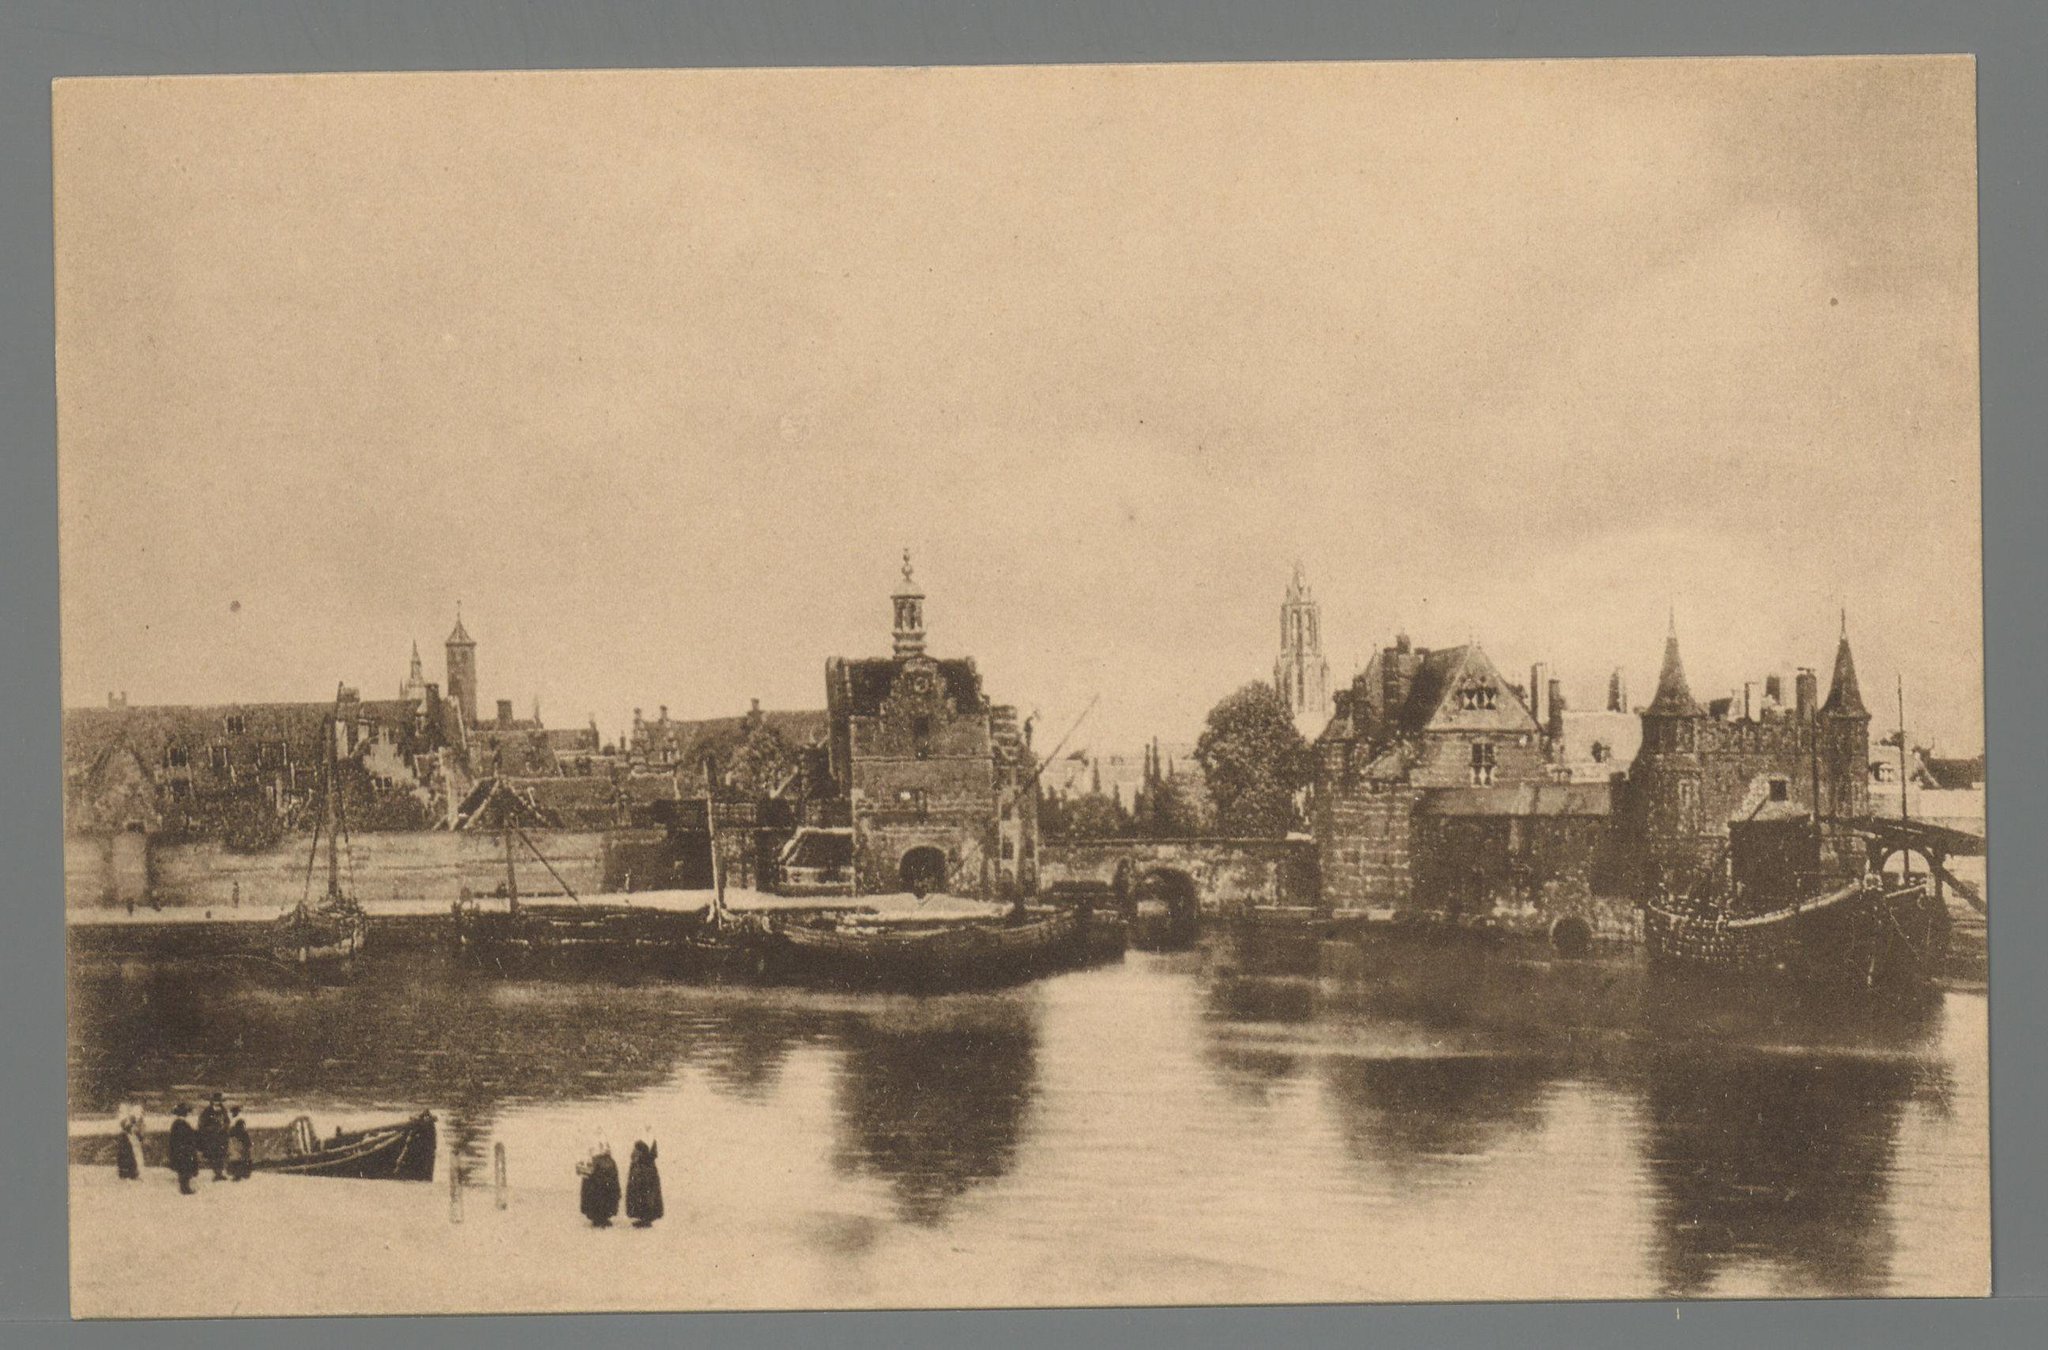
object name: reproduction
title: Johannes Vermeer. Gezicht op Delft / Vue de Delft / View of Delft / Ansicht von Delft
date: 1906-1930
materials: cardboard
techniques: photograph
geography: the hague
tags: city-view, and landscape with man-made constructions, church (exterior), city-gate, delft